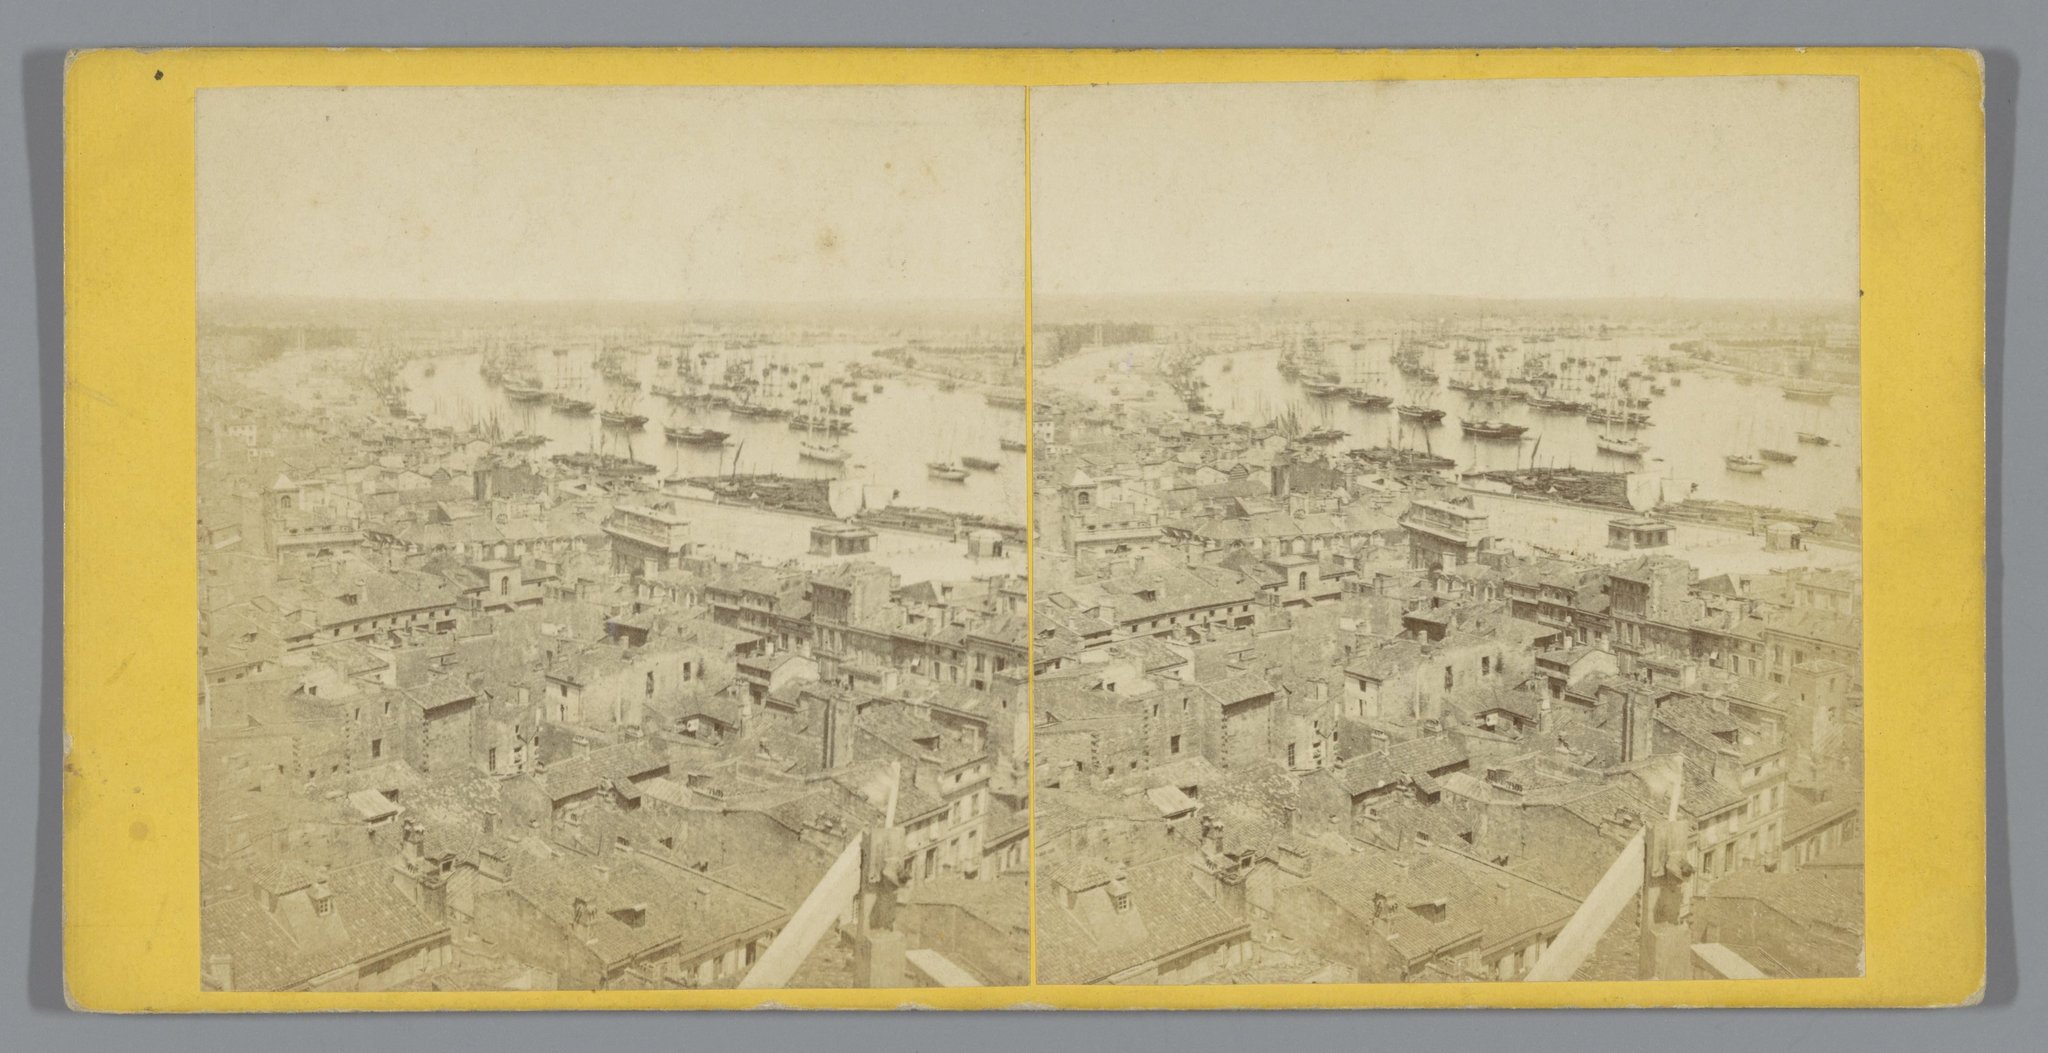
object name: stereograph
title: Gezicht op Bordeaux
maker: Anonymous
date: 1860-1880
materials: cardboard, photographic support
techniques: albumen print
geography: bordeaux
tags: bordeaux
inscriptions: inscription: ‘Rade Bordeaux’, number: ‘270’